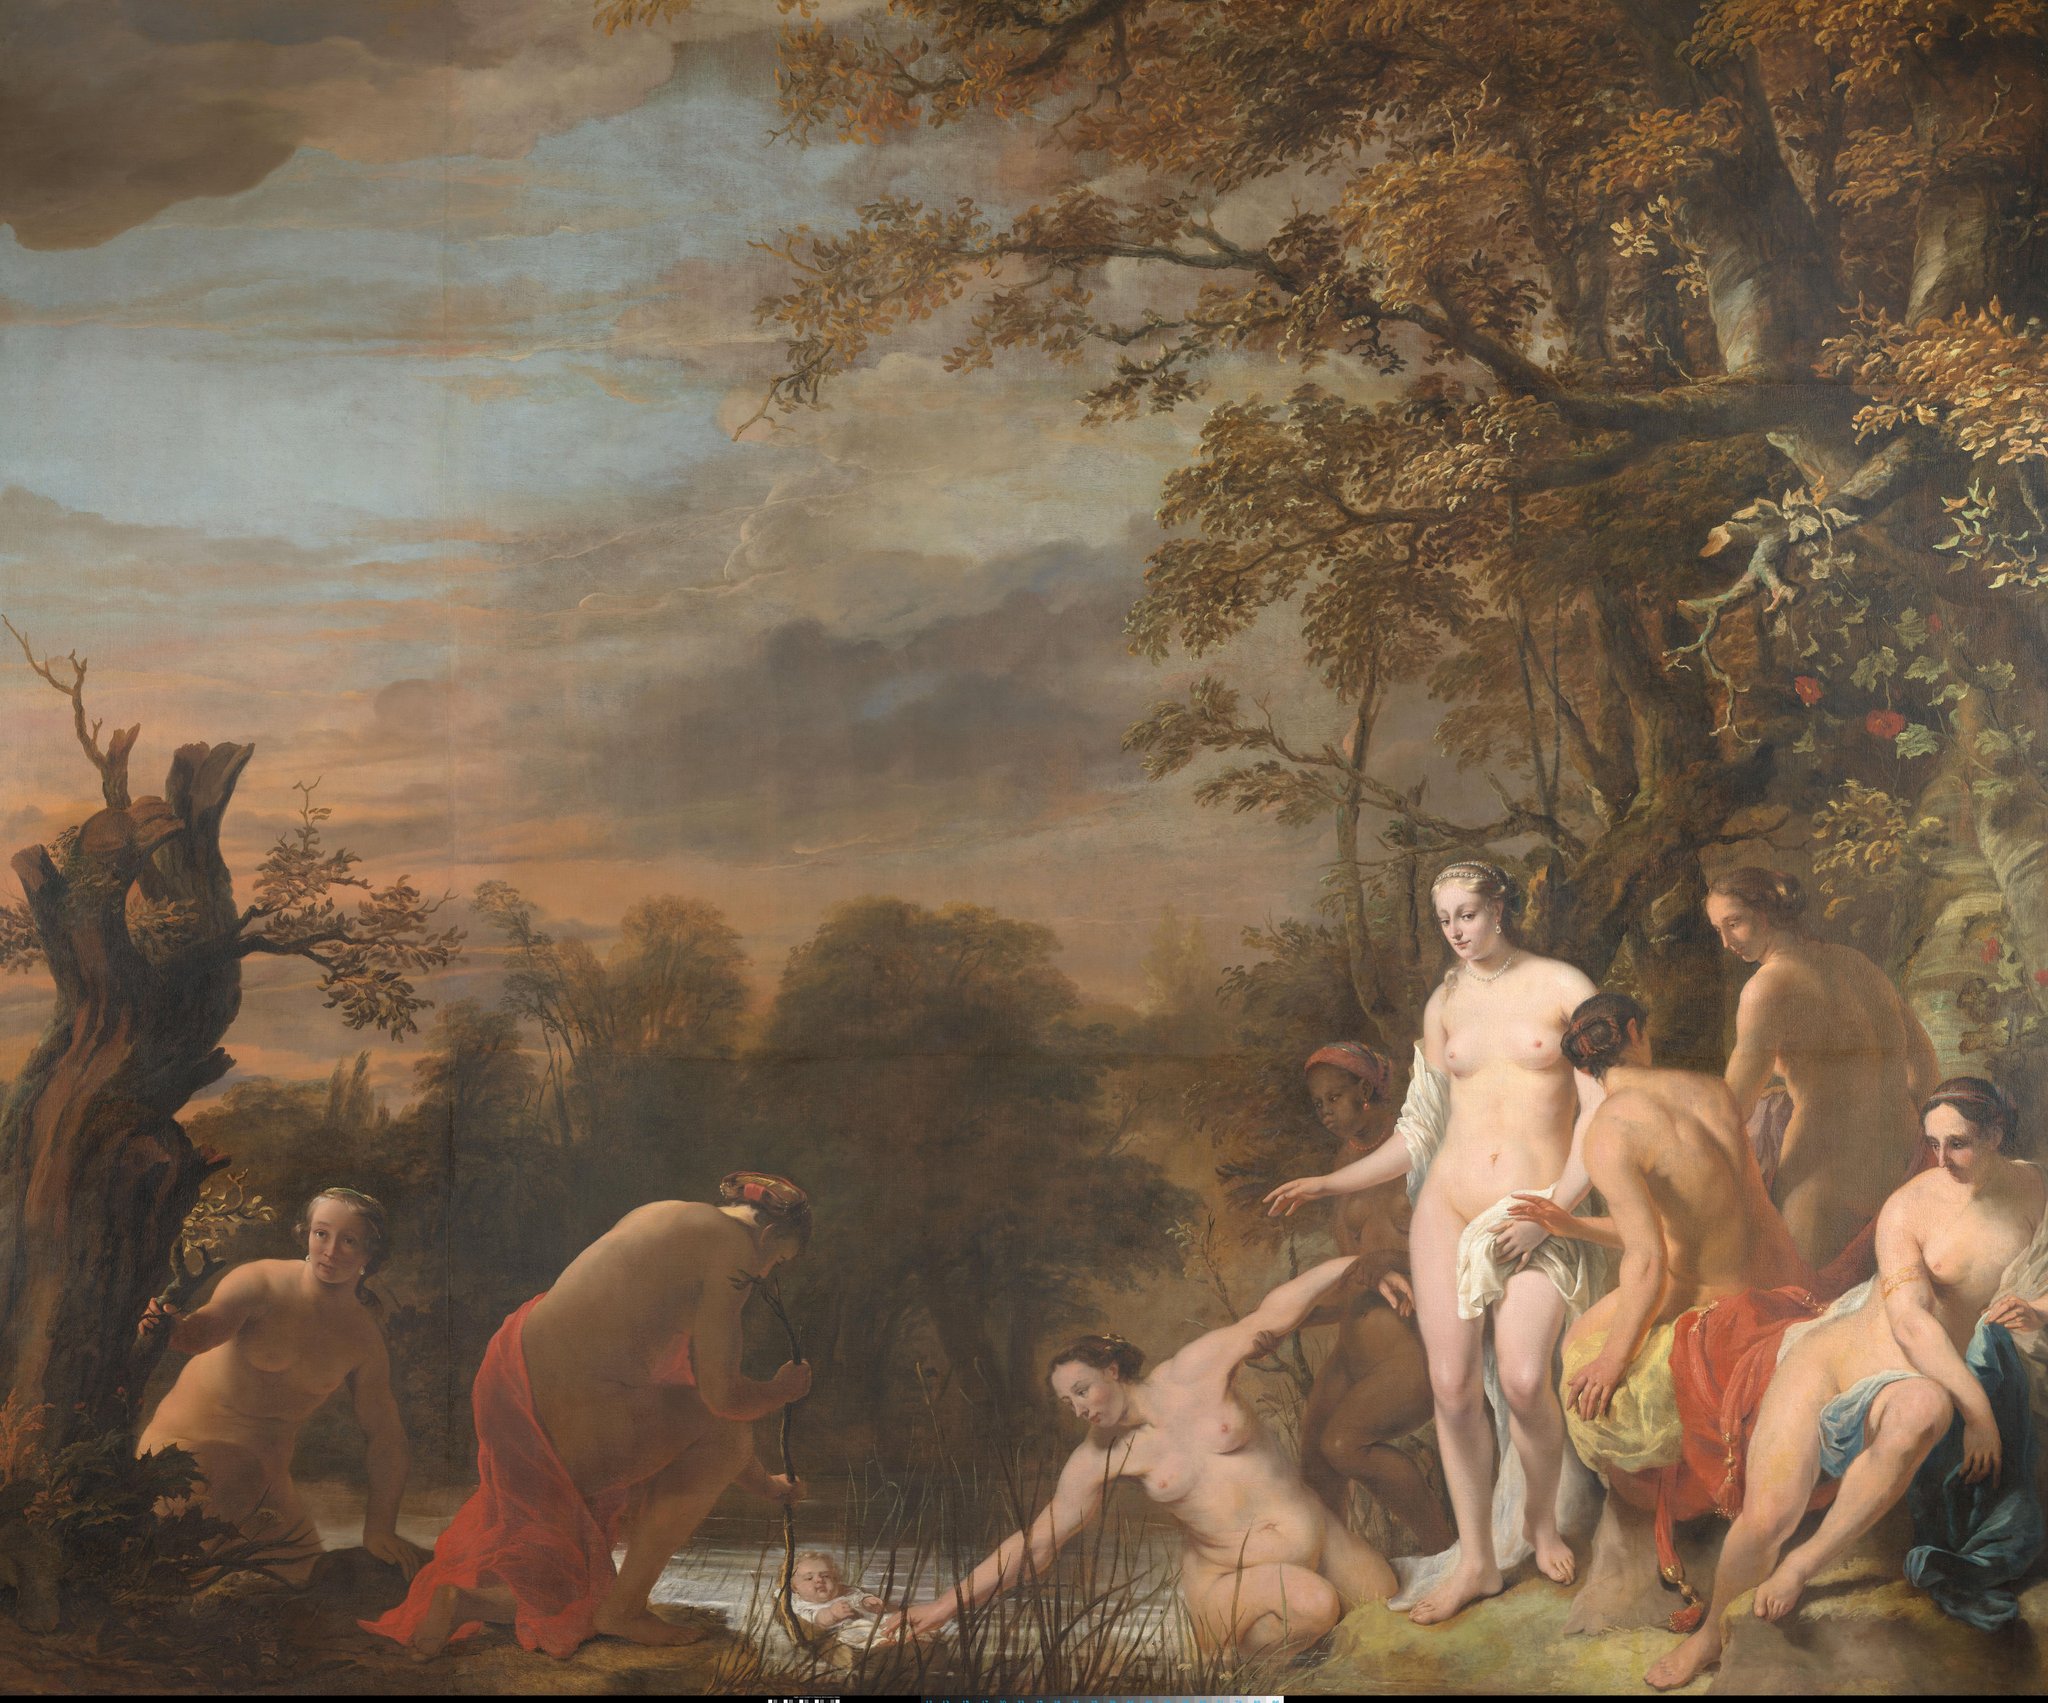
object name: wall decoration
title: Pharoah's Daughter Discovers Moses in the Rush Basket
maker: ferdinand bol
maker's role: draughtsman, painter, print maker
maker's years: 1616-1680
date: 1660-1663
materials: canvas, oil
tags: moses is pulled out of the water by the servants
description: Farao's dochter vindt Mozes in het biezen mandje. De dochter van de Farao is met haar gezelschapsdames, waaronder een negerin, bij de waterkant aan het baden. Twee vrouwen vissen met mandje uit het water. Onderdeel van een groep van vijf werken vervaardigd voor het huis aan de Nieuwegracht 6 te Utrecht.